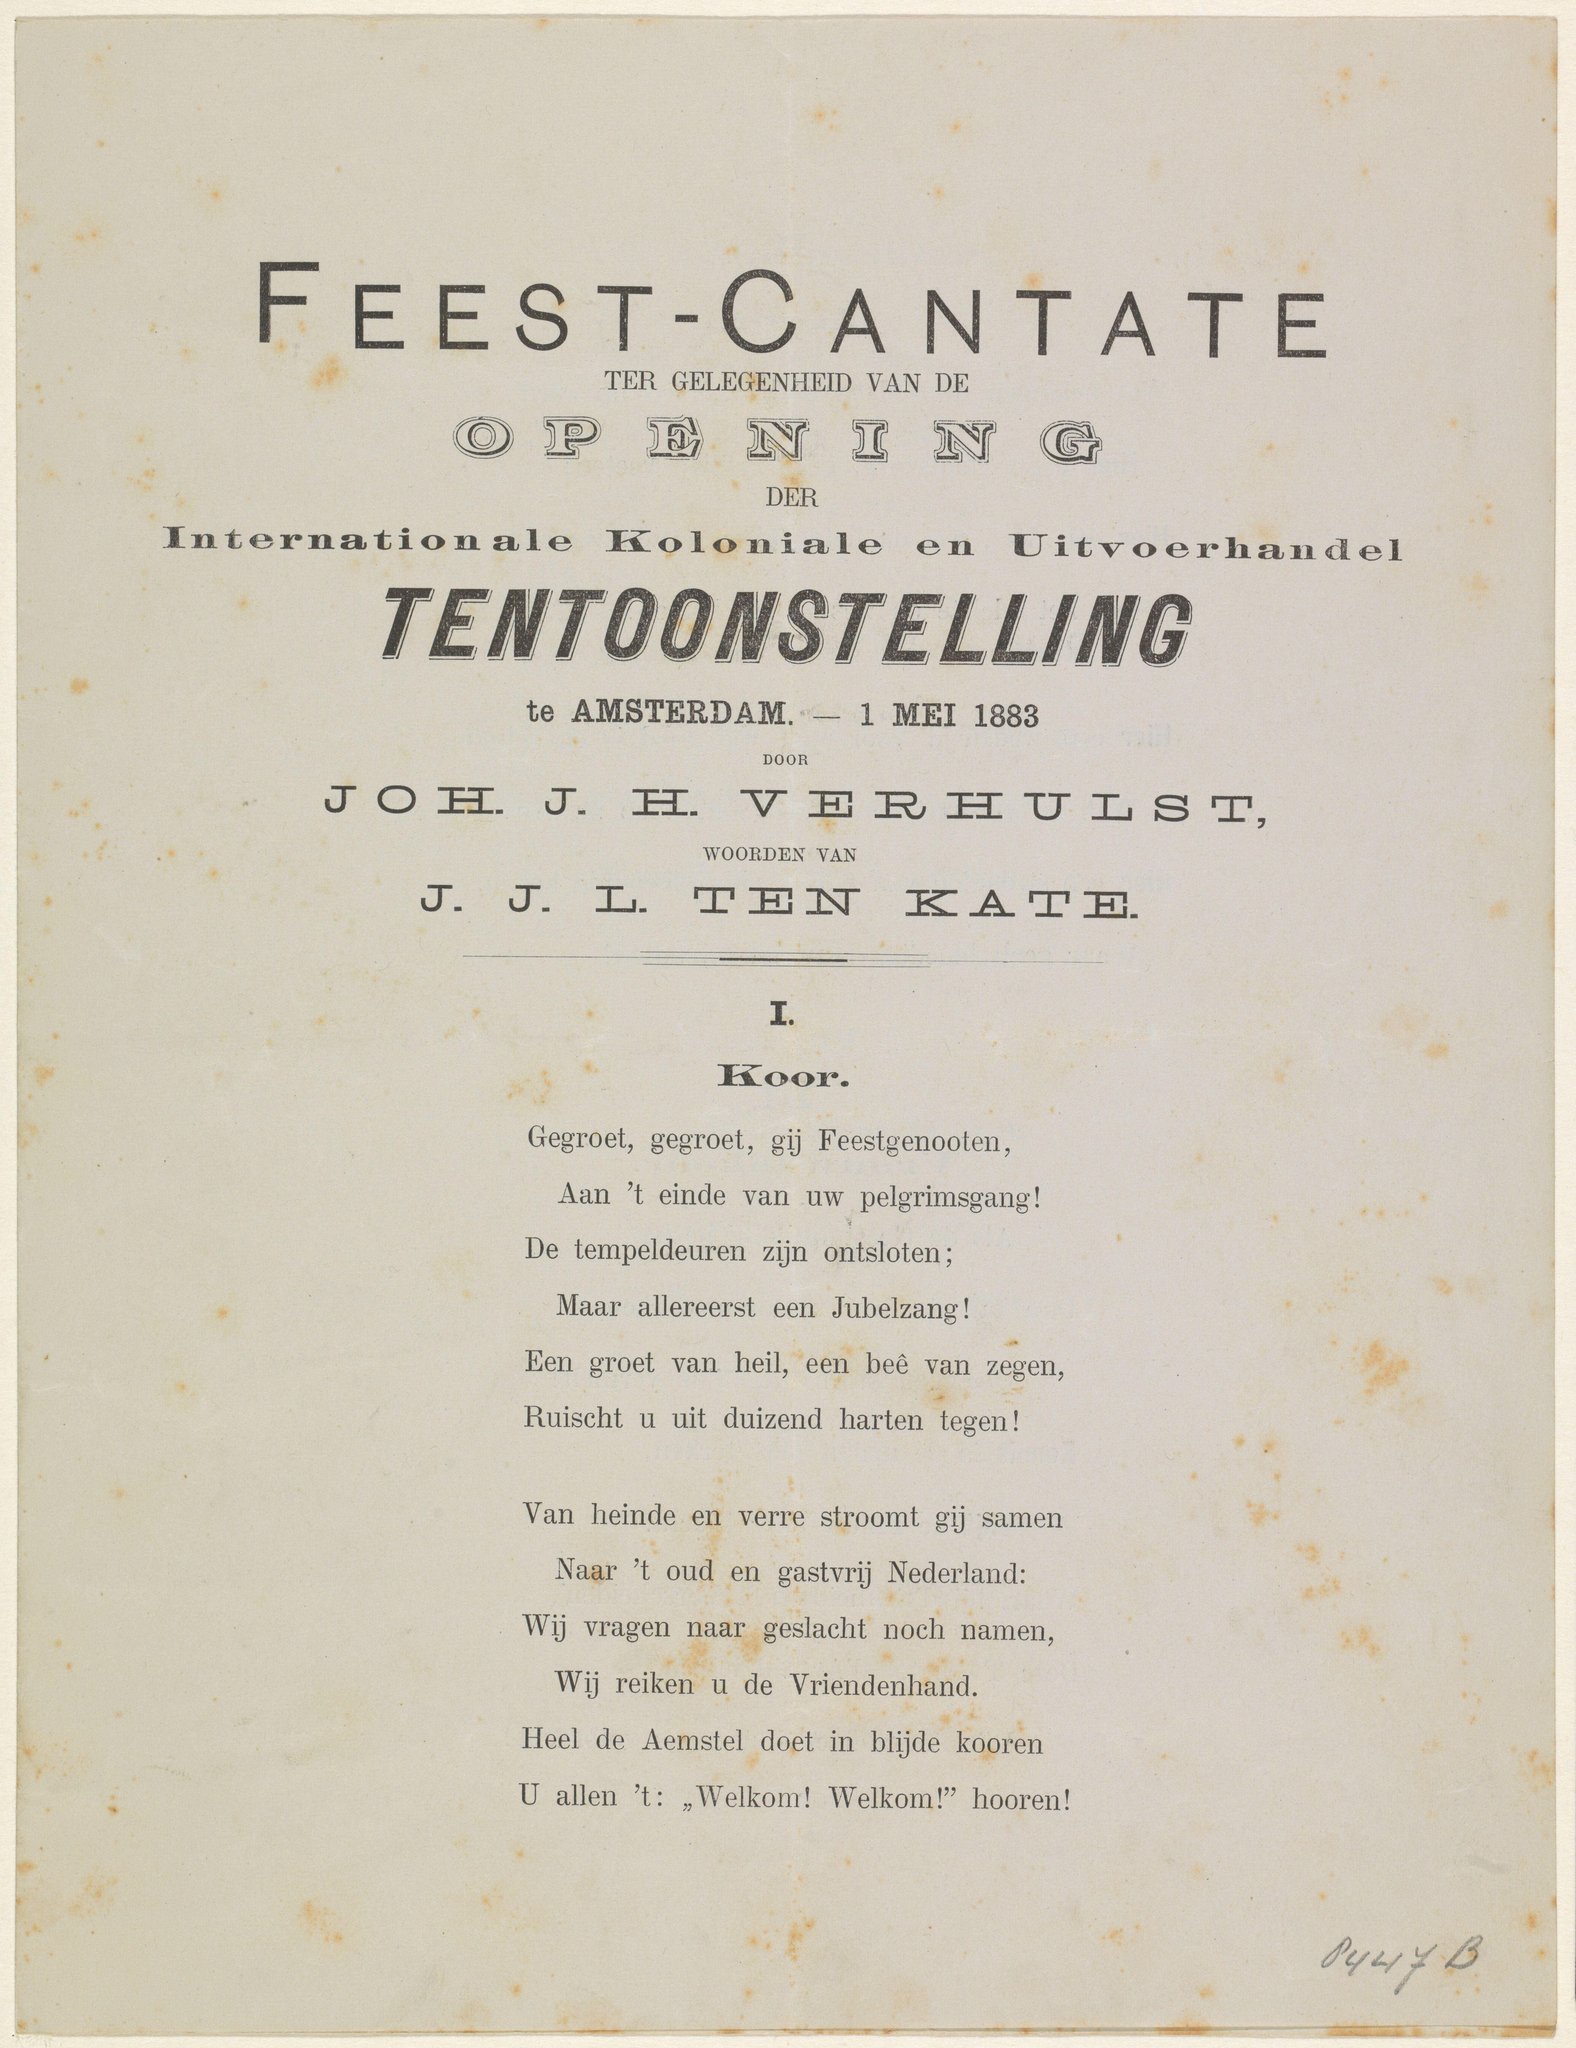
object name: text sheet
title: Feest-Cantate ter gelegenheid van de opening der Internationale Koloniale en Uitvoerhandel Tentoonstelling te Amsterdam. - 1 mei 1883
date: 1883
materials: paper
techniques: letterpress printing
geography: netherlands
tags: world fair, world exhibition, amsterdam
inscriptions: collector's mark: Lugt 2228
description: Blad met de tekst van het feestlied ter ere van de opening van de Wereldtentoonstelling (Internationale Koloniale en Uitvoerhandel Tentoonstelling) op het Museumplein te Amsterdam op 1 mei 1883. Muziek door Joahnnes Verhulst, woorden van J.J.L Ten Kate. Dubbelgevouwen blad bedrukt op alle zijden.